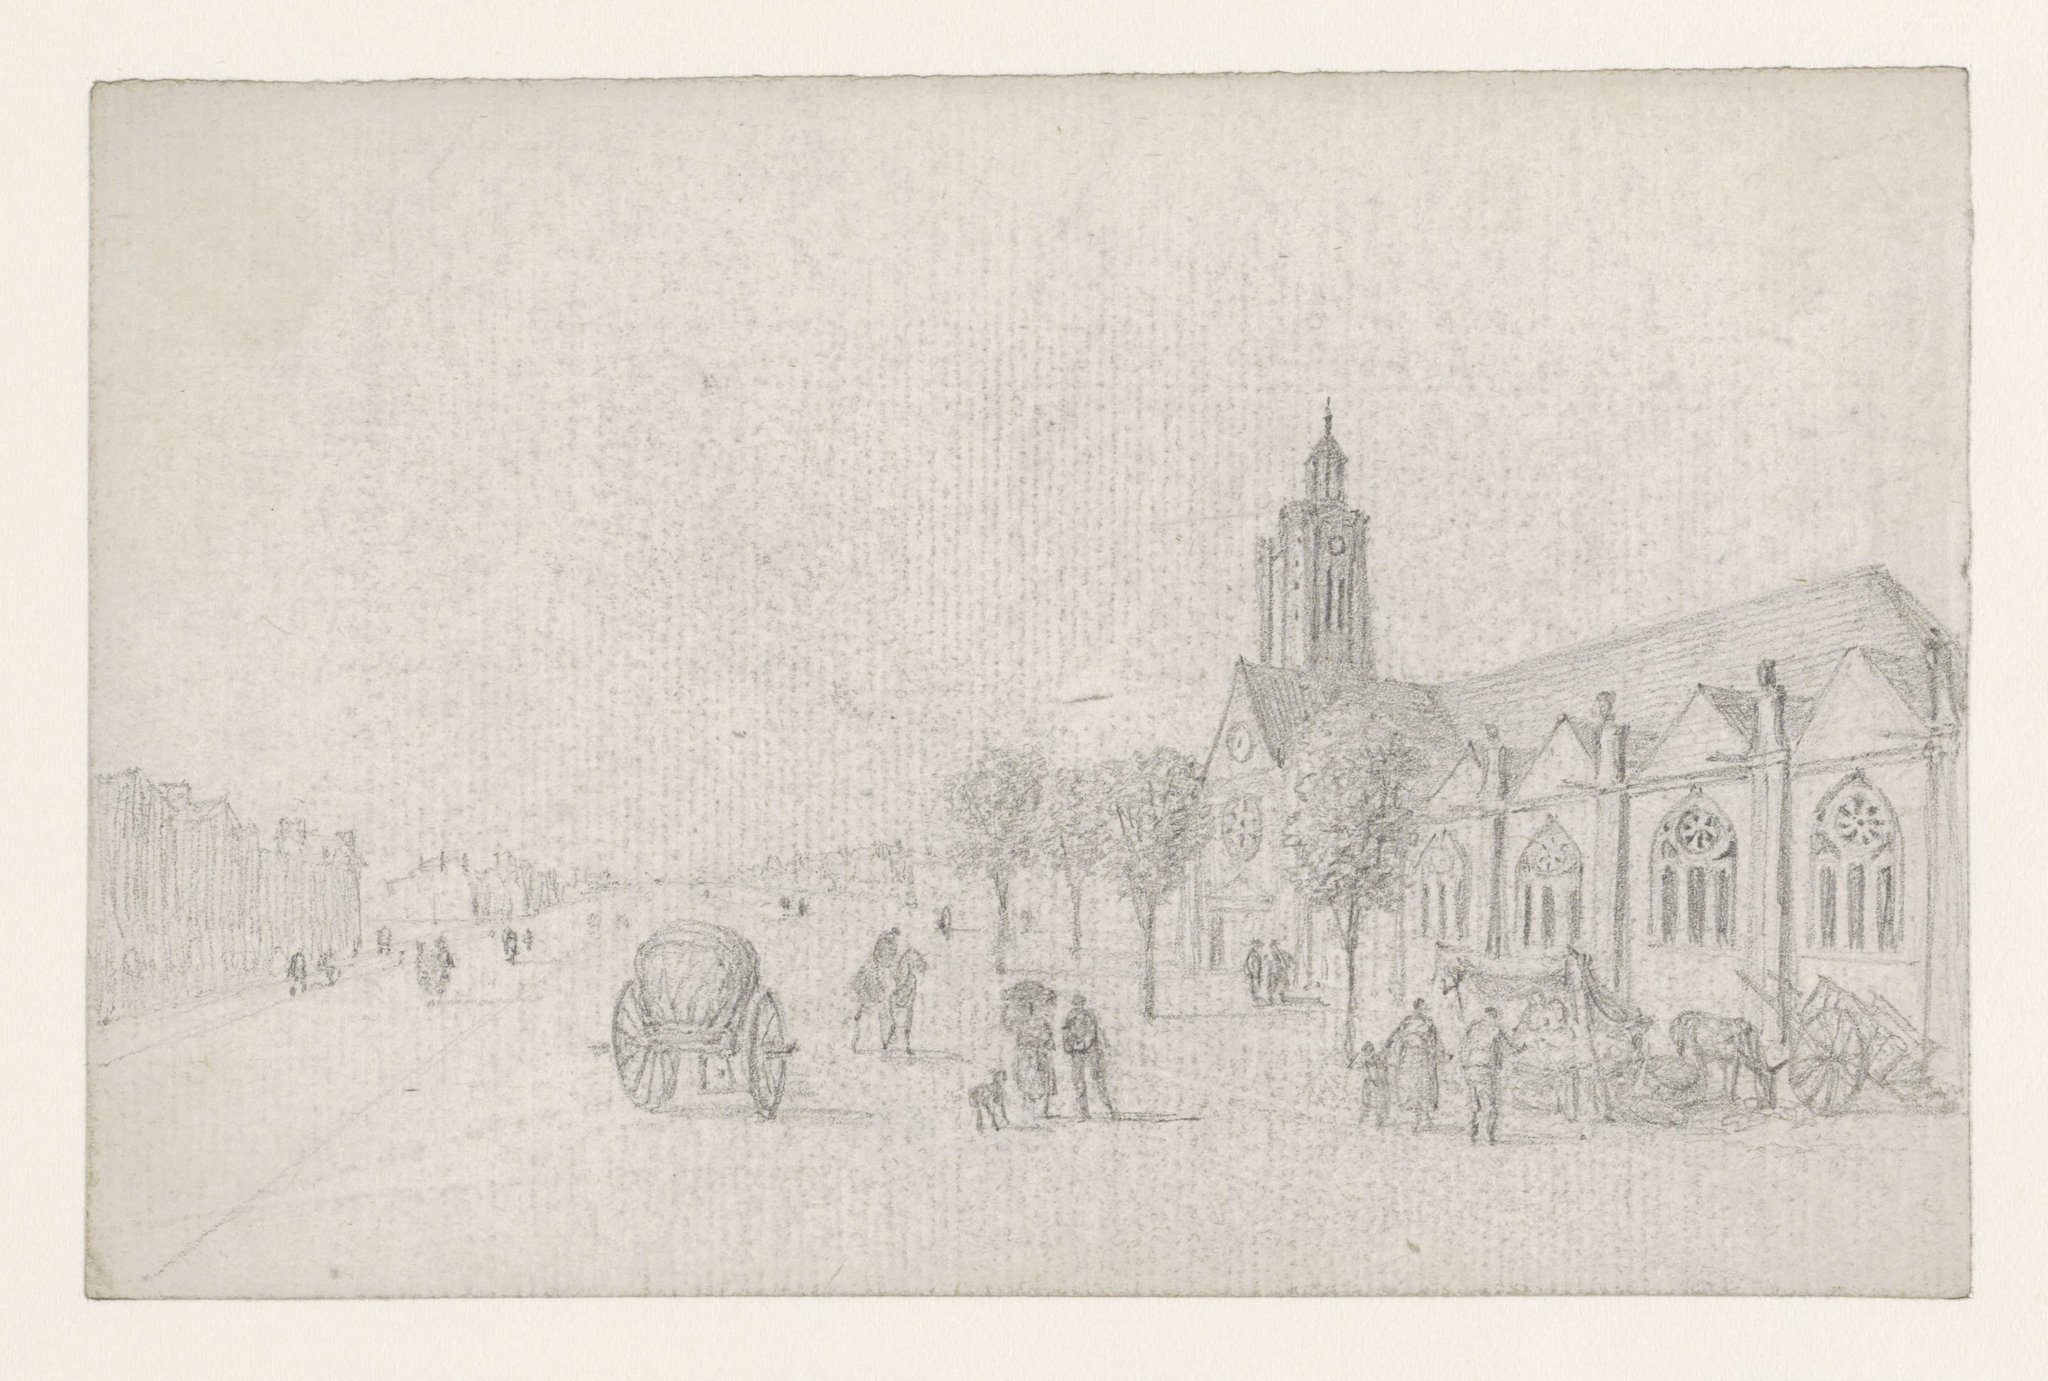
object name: drawing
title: Saint Nicolas des Champs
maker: georges michel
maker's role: draughtsman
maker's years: 1763-1843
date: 1773-1843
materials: paper, pencil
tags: church (exterior), street (+ city(-scape) with figures, staffage), paris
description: Een van 120 tekeningen, afkomstig uit een 19e eeuws album met tekeningen van Georges Michel.